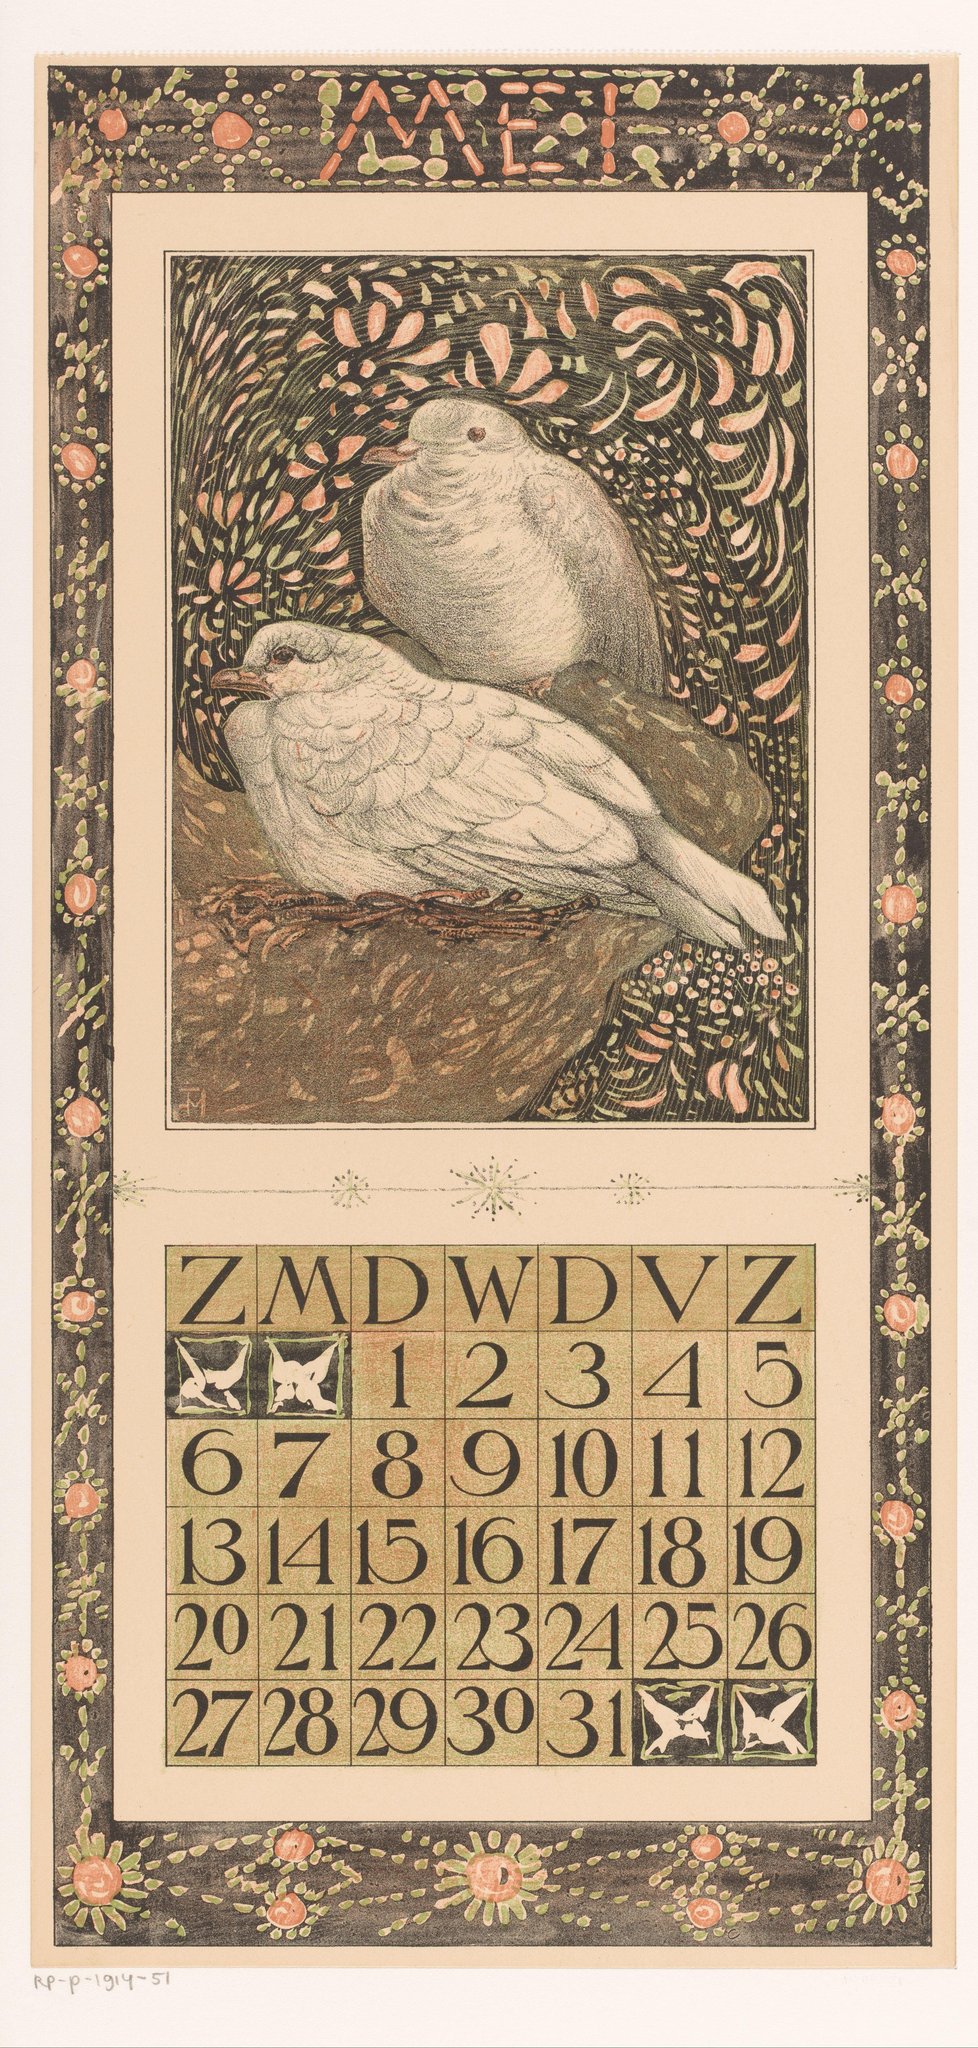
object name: calendar leaf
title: Kalenderblad mei met twee duiven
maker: theo van hoytema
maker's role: draughtsman, painter, print maker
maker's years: 1863-1917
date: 1905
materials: paper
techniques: lithograph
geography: amsterdam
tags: may ~ other concepts, doves, pigeons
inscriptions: collector's mark: Lugt 2228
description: De duiven zitten bij een nest. Bovenaan het blad een scheurlijn.